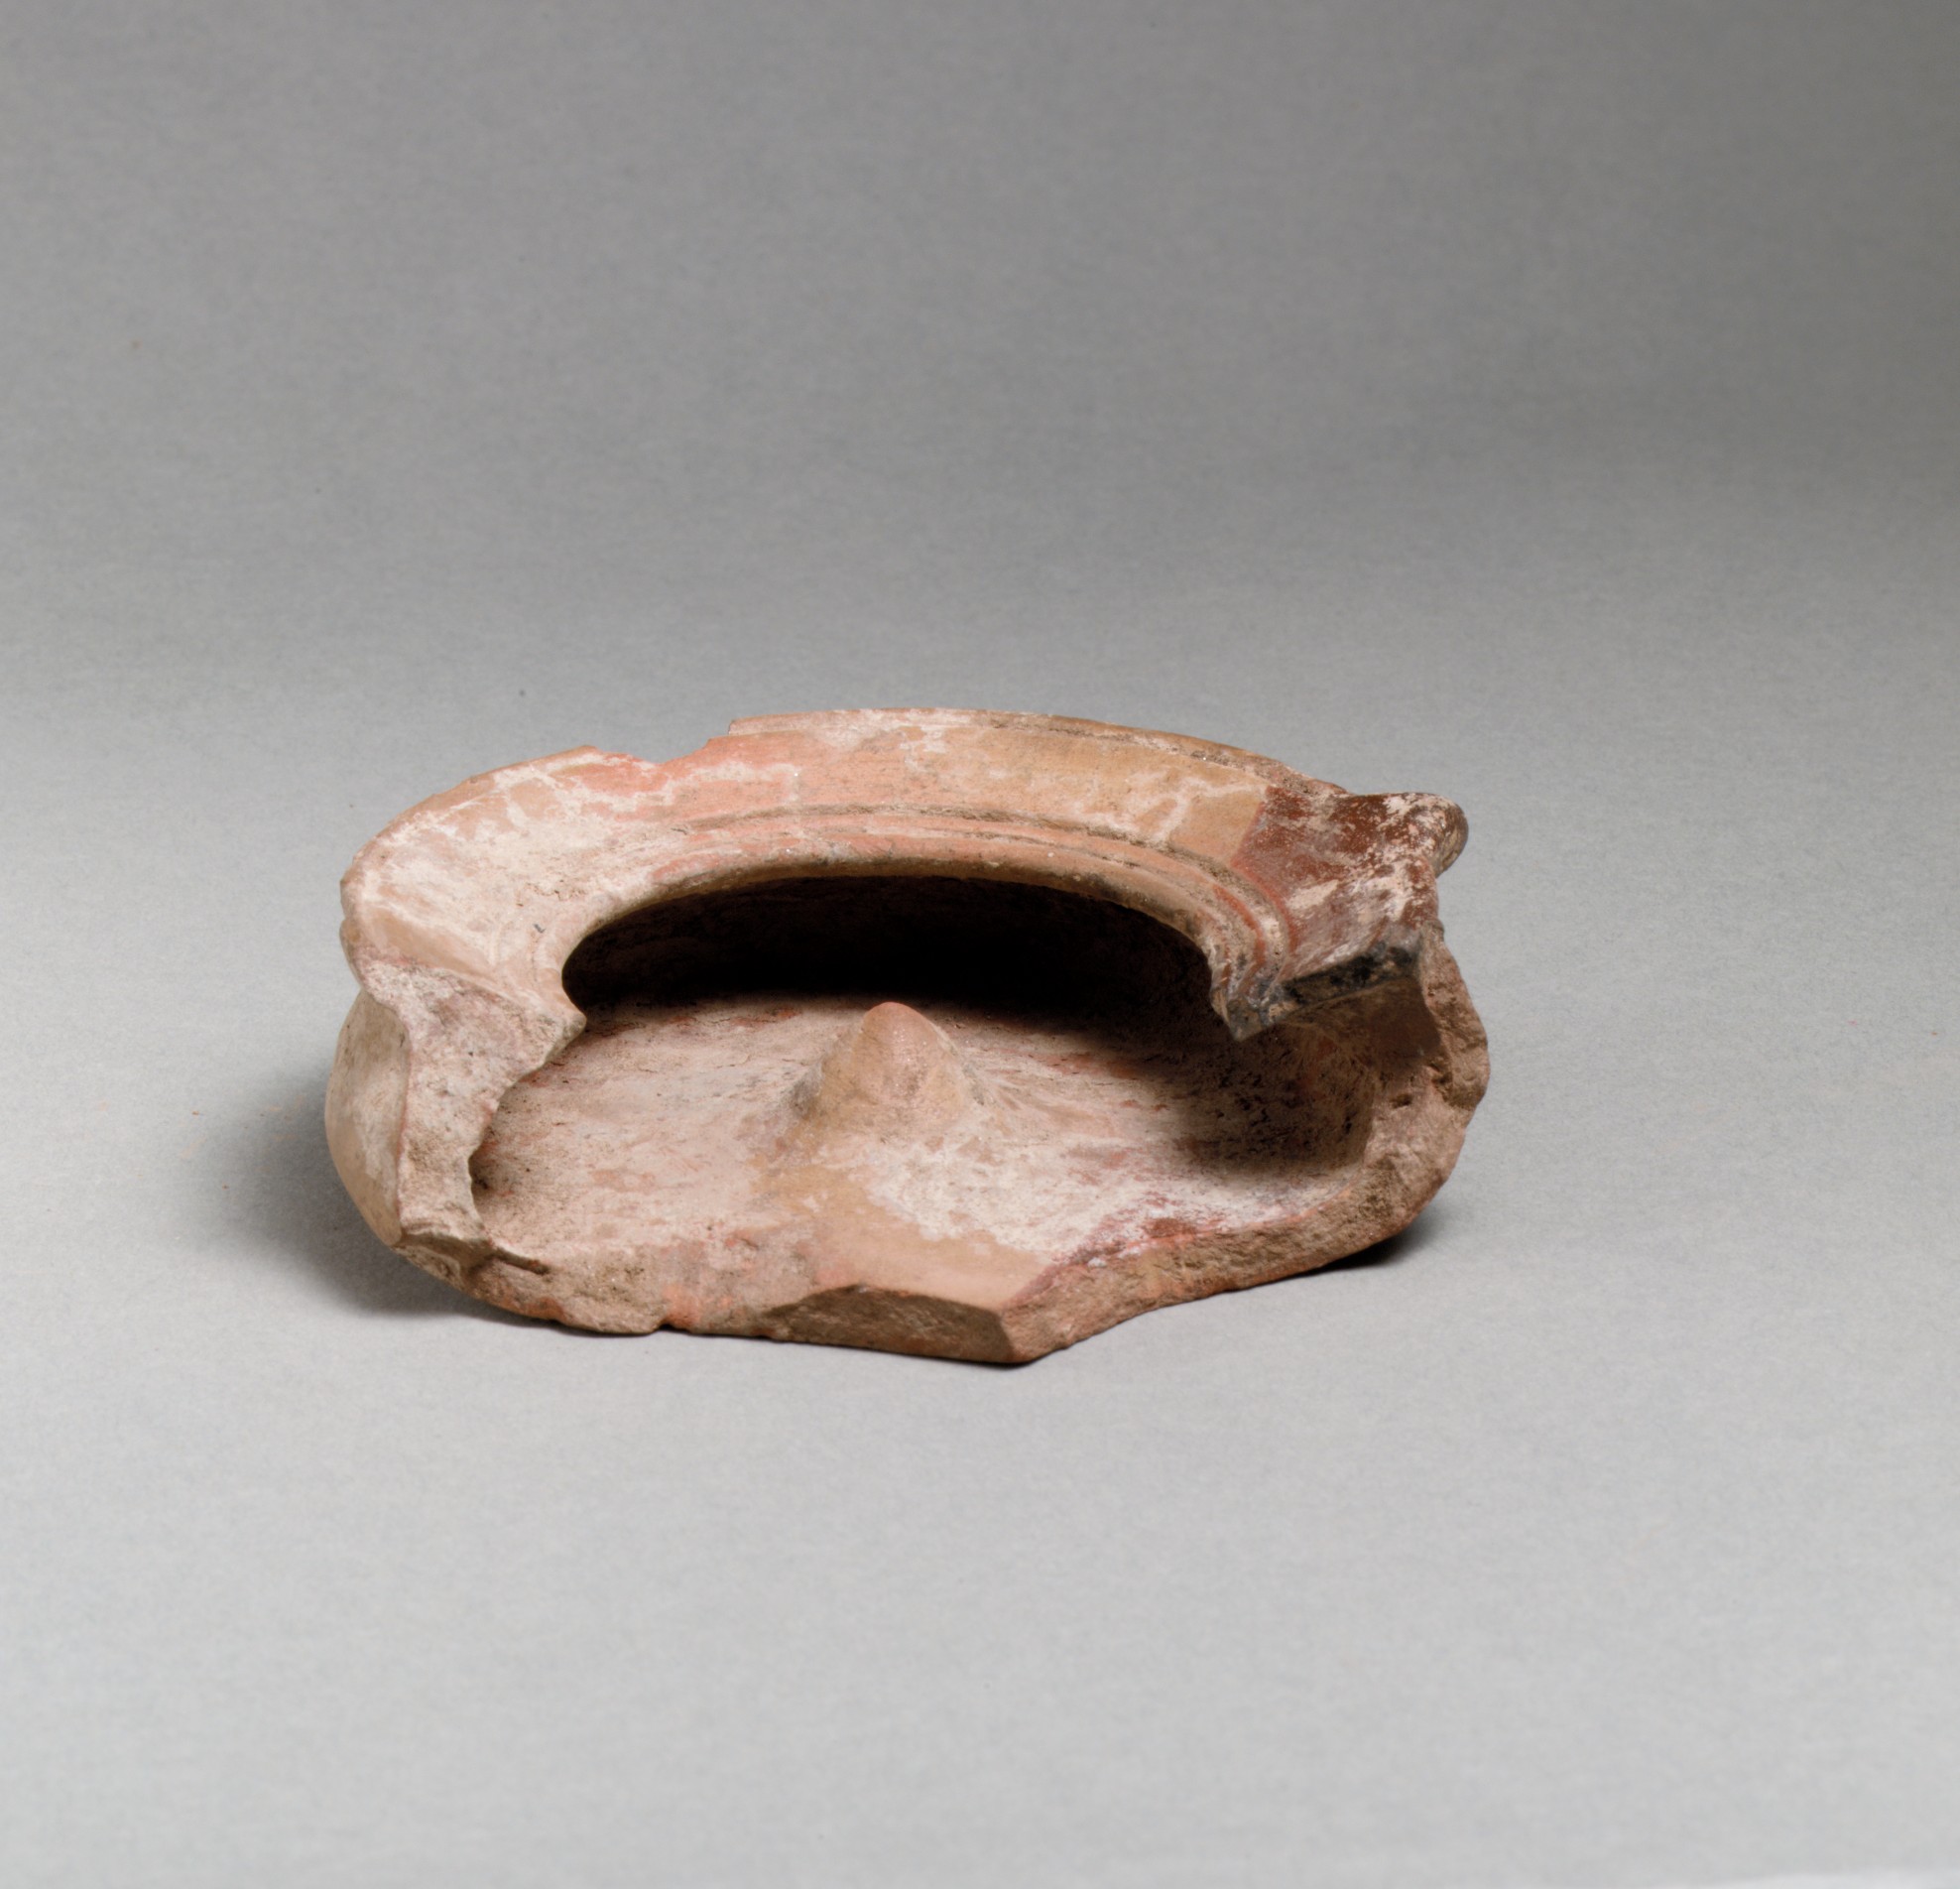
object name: lamp fragment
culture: greek or lydian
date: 900-30 BCE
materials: terracotta